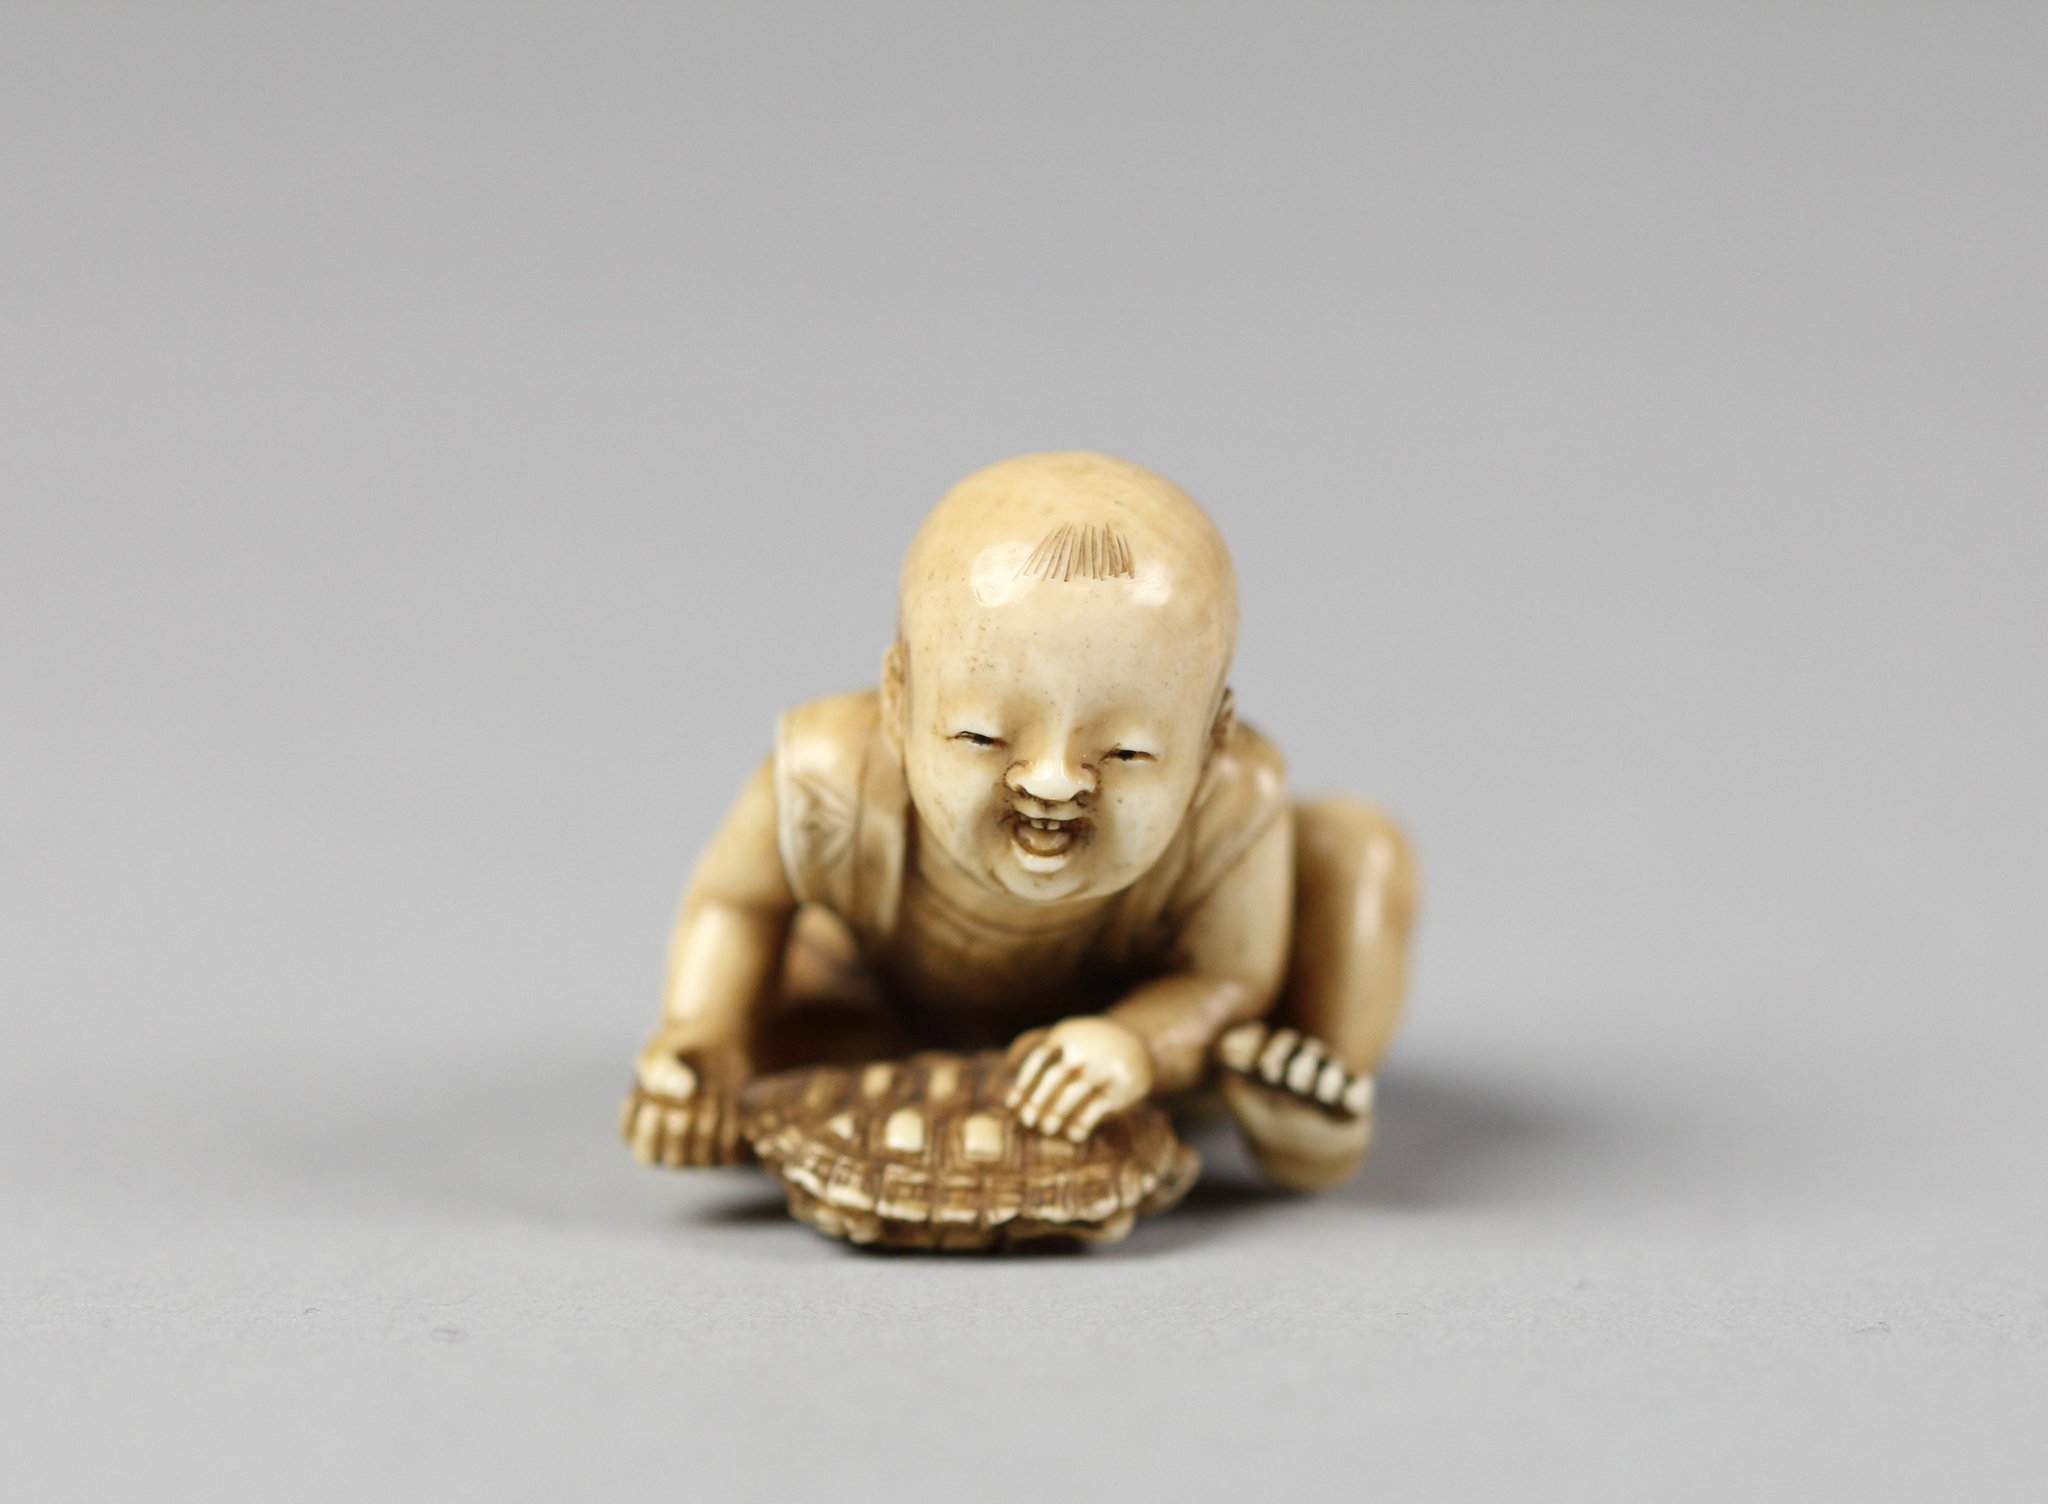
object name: netsuke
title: Netsuke of Child with a Turtle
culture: japanese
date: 1801-1900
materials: ivory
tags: children